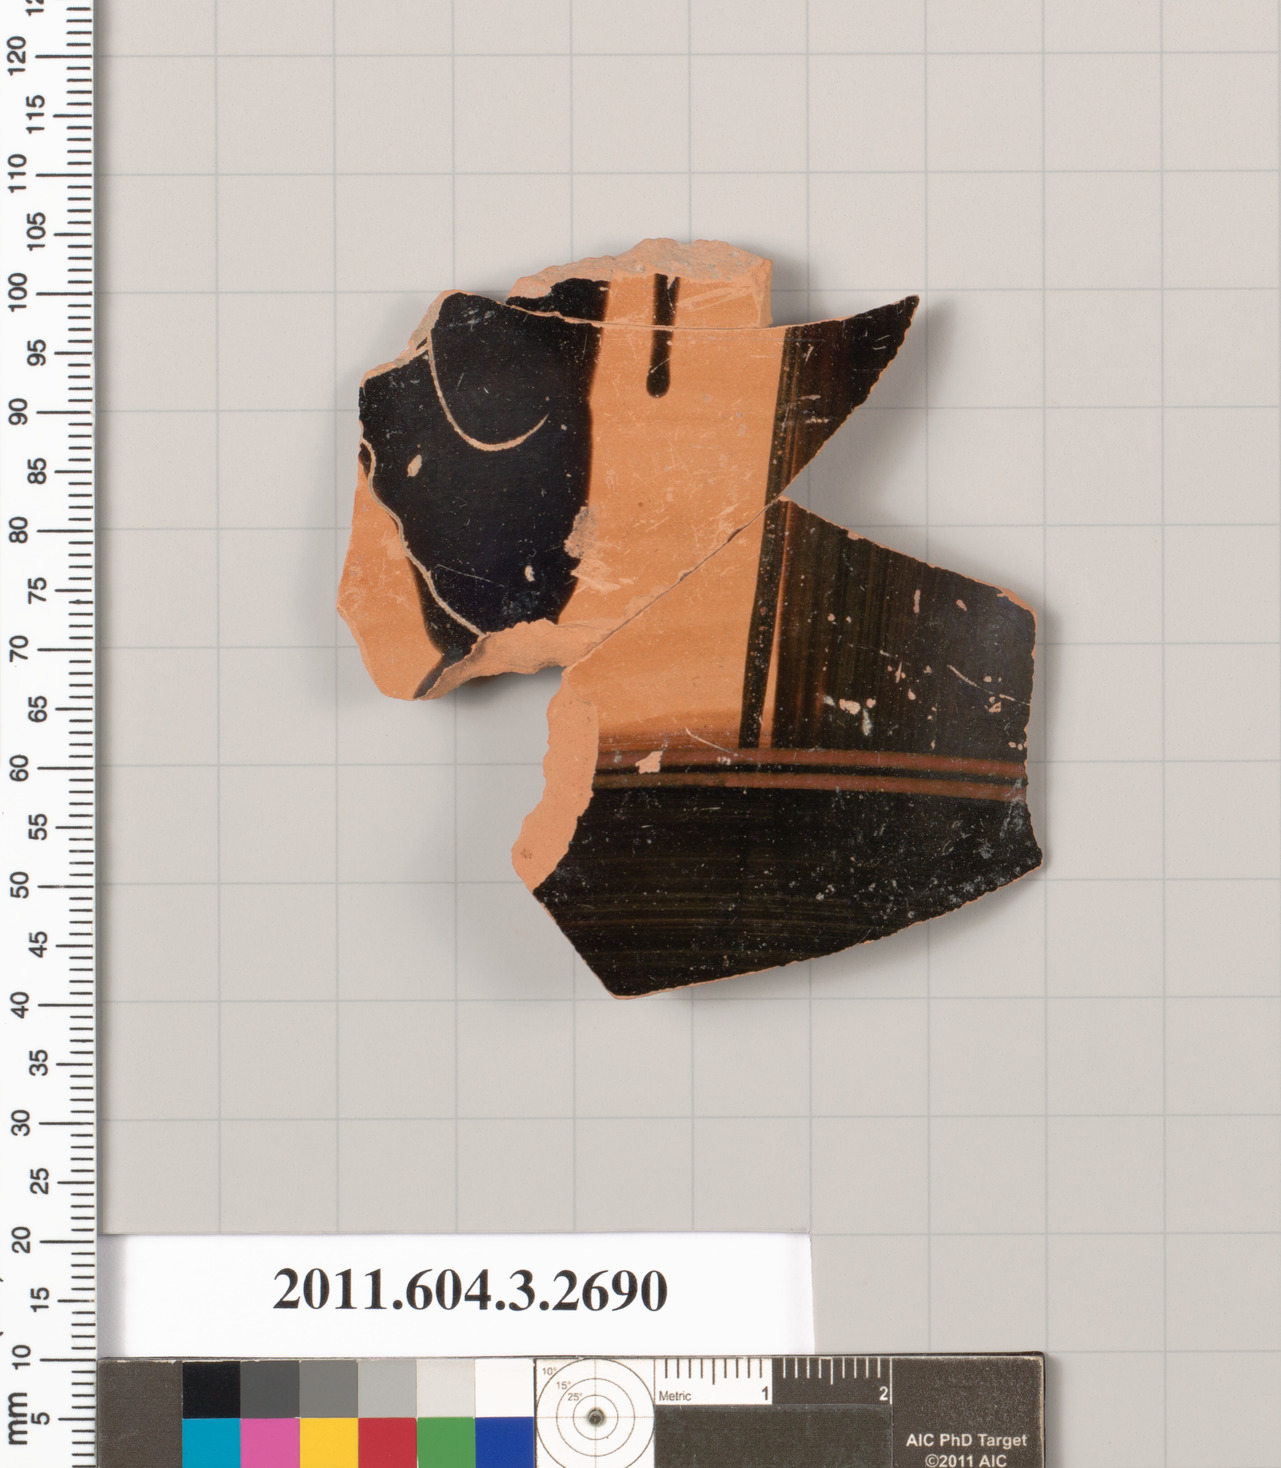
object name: oinochoe fragment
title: Terracotta fragment of an oinochoe (jug)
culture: greek, attic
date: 534-468 BCE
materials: terracotta